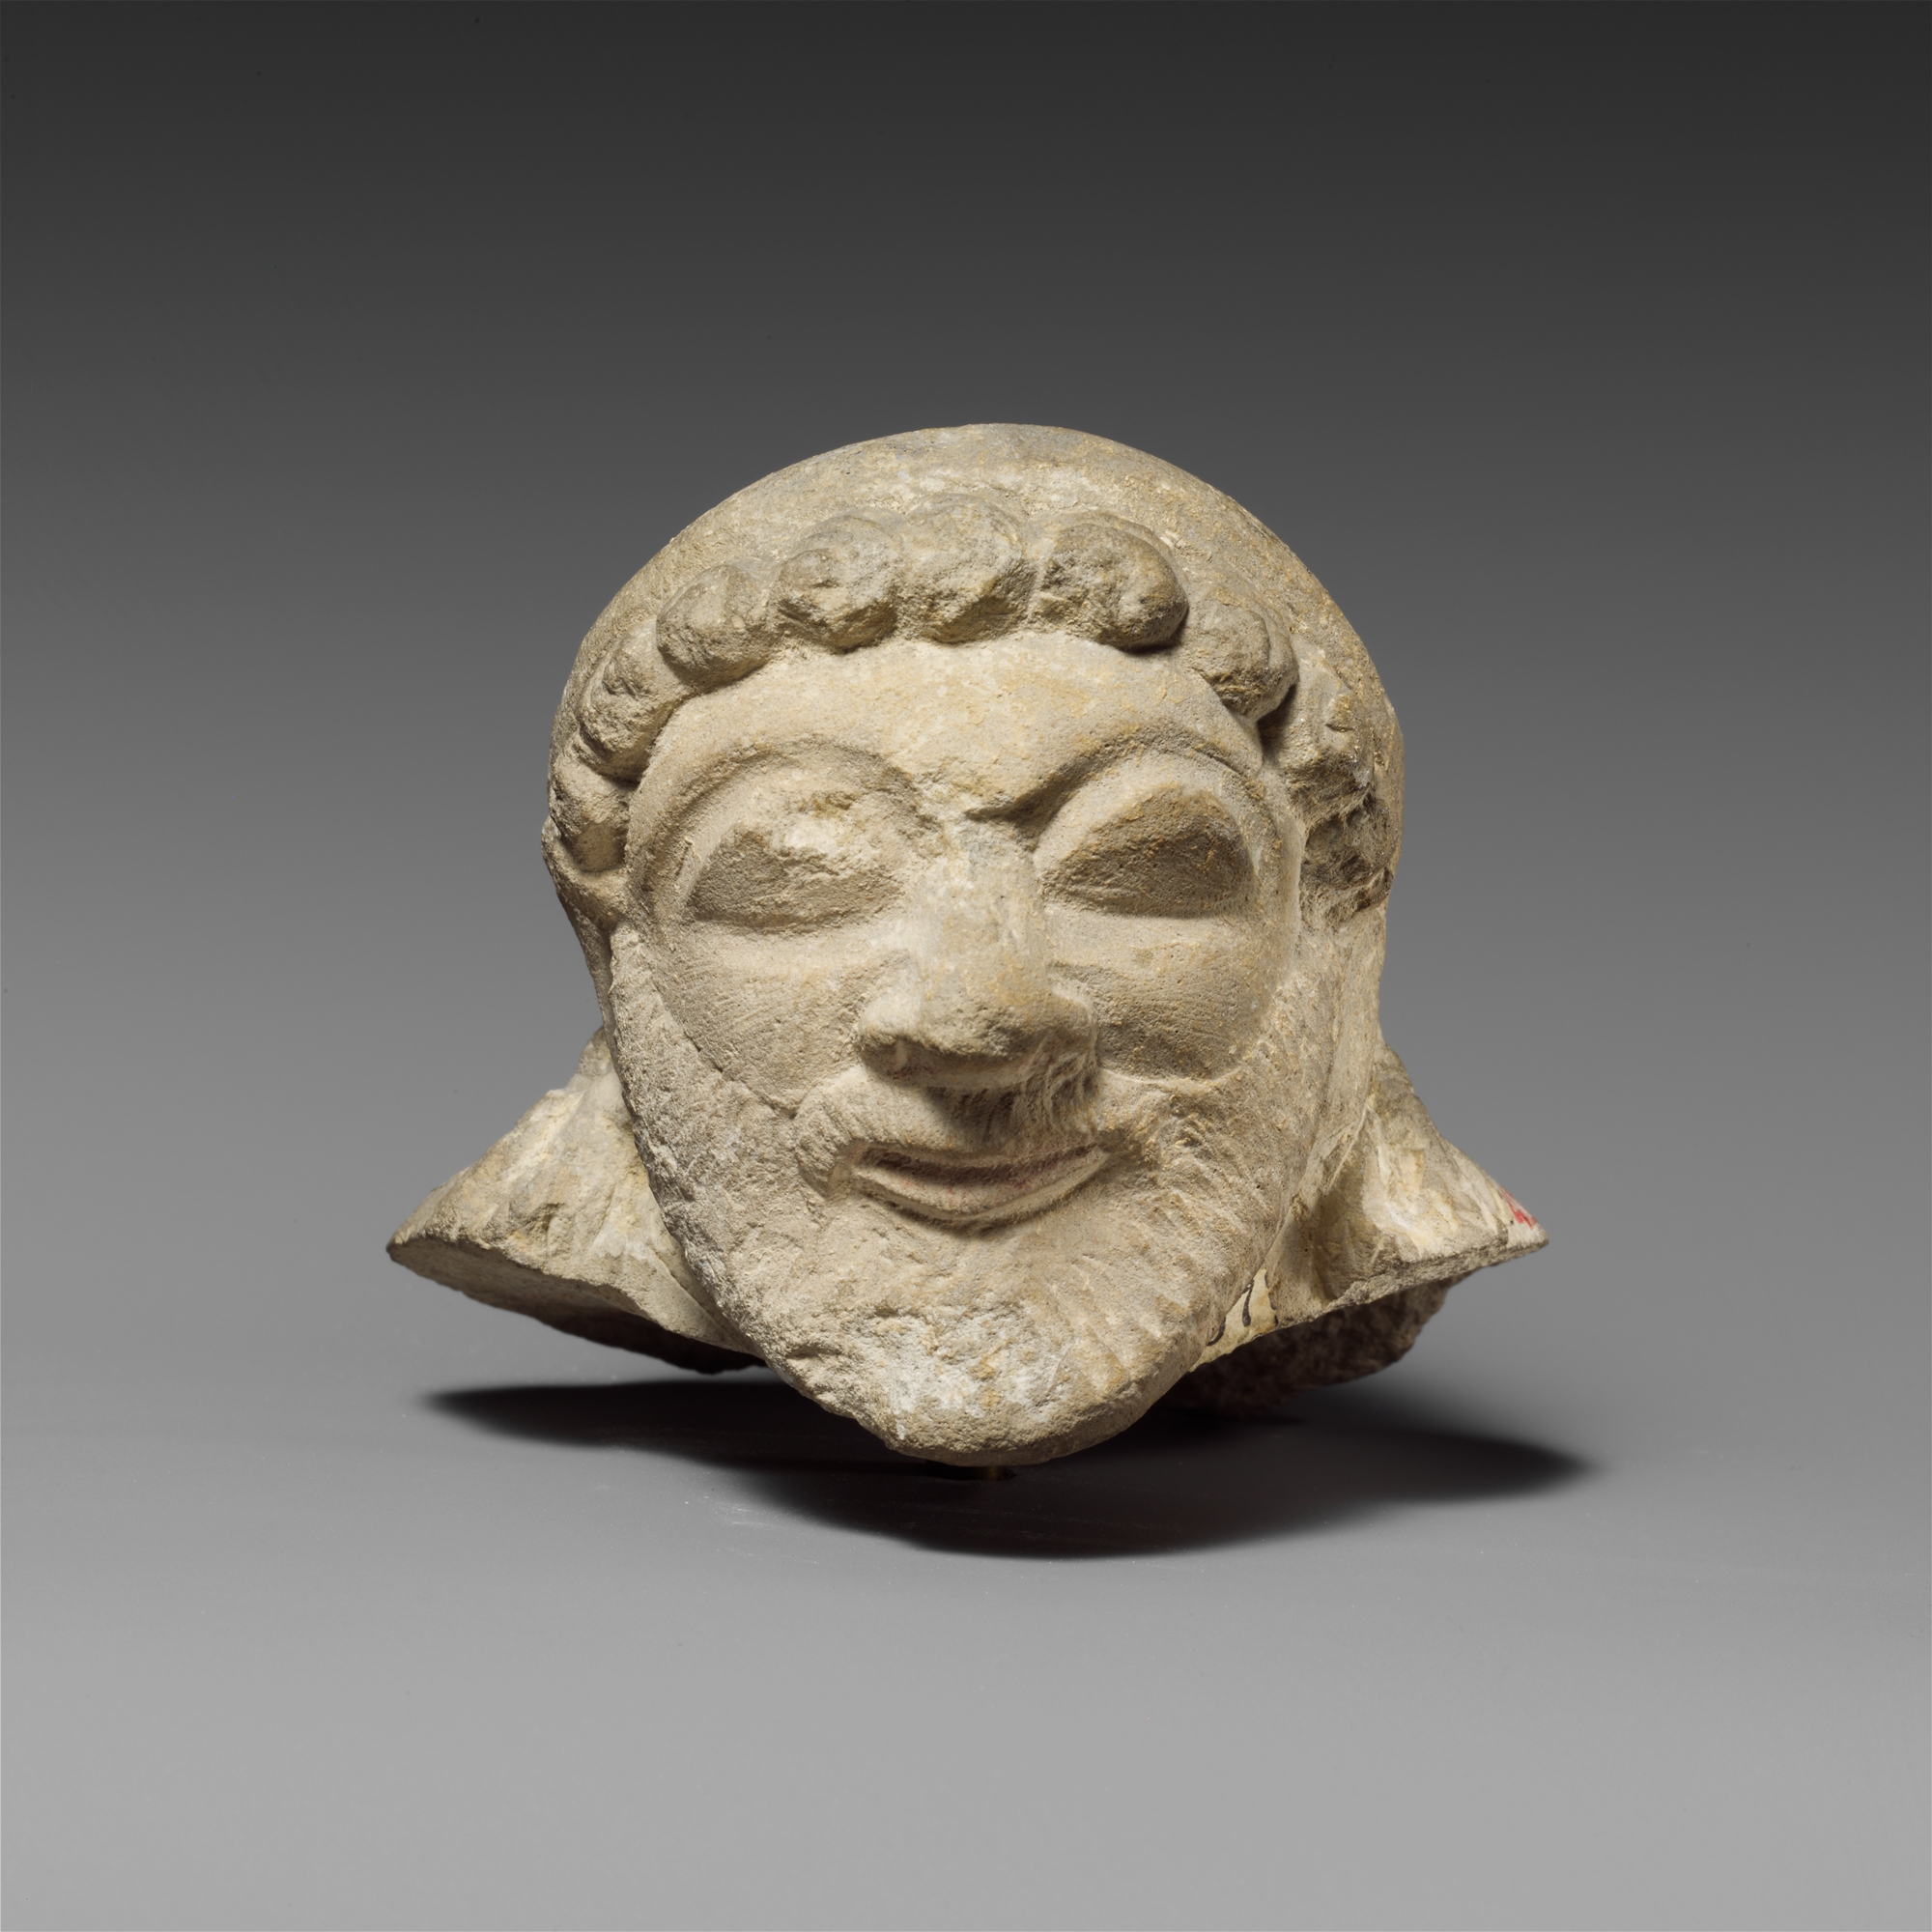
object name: head of a man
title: Limestone head of a silen (?)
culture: cypriot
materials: limestone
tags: heads,silenus